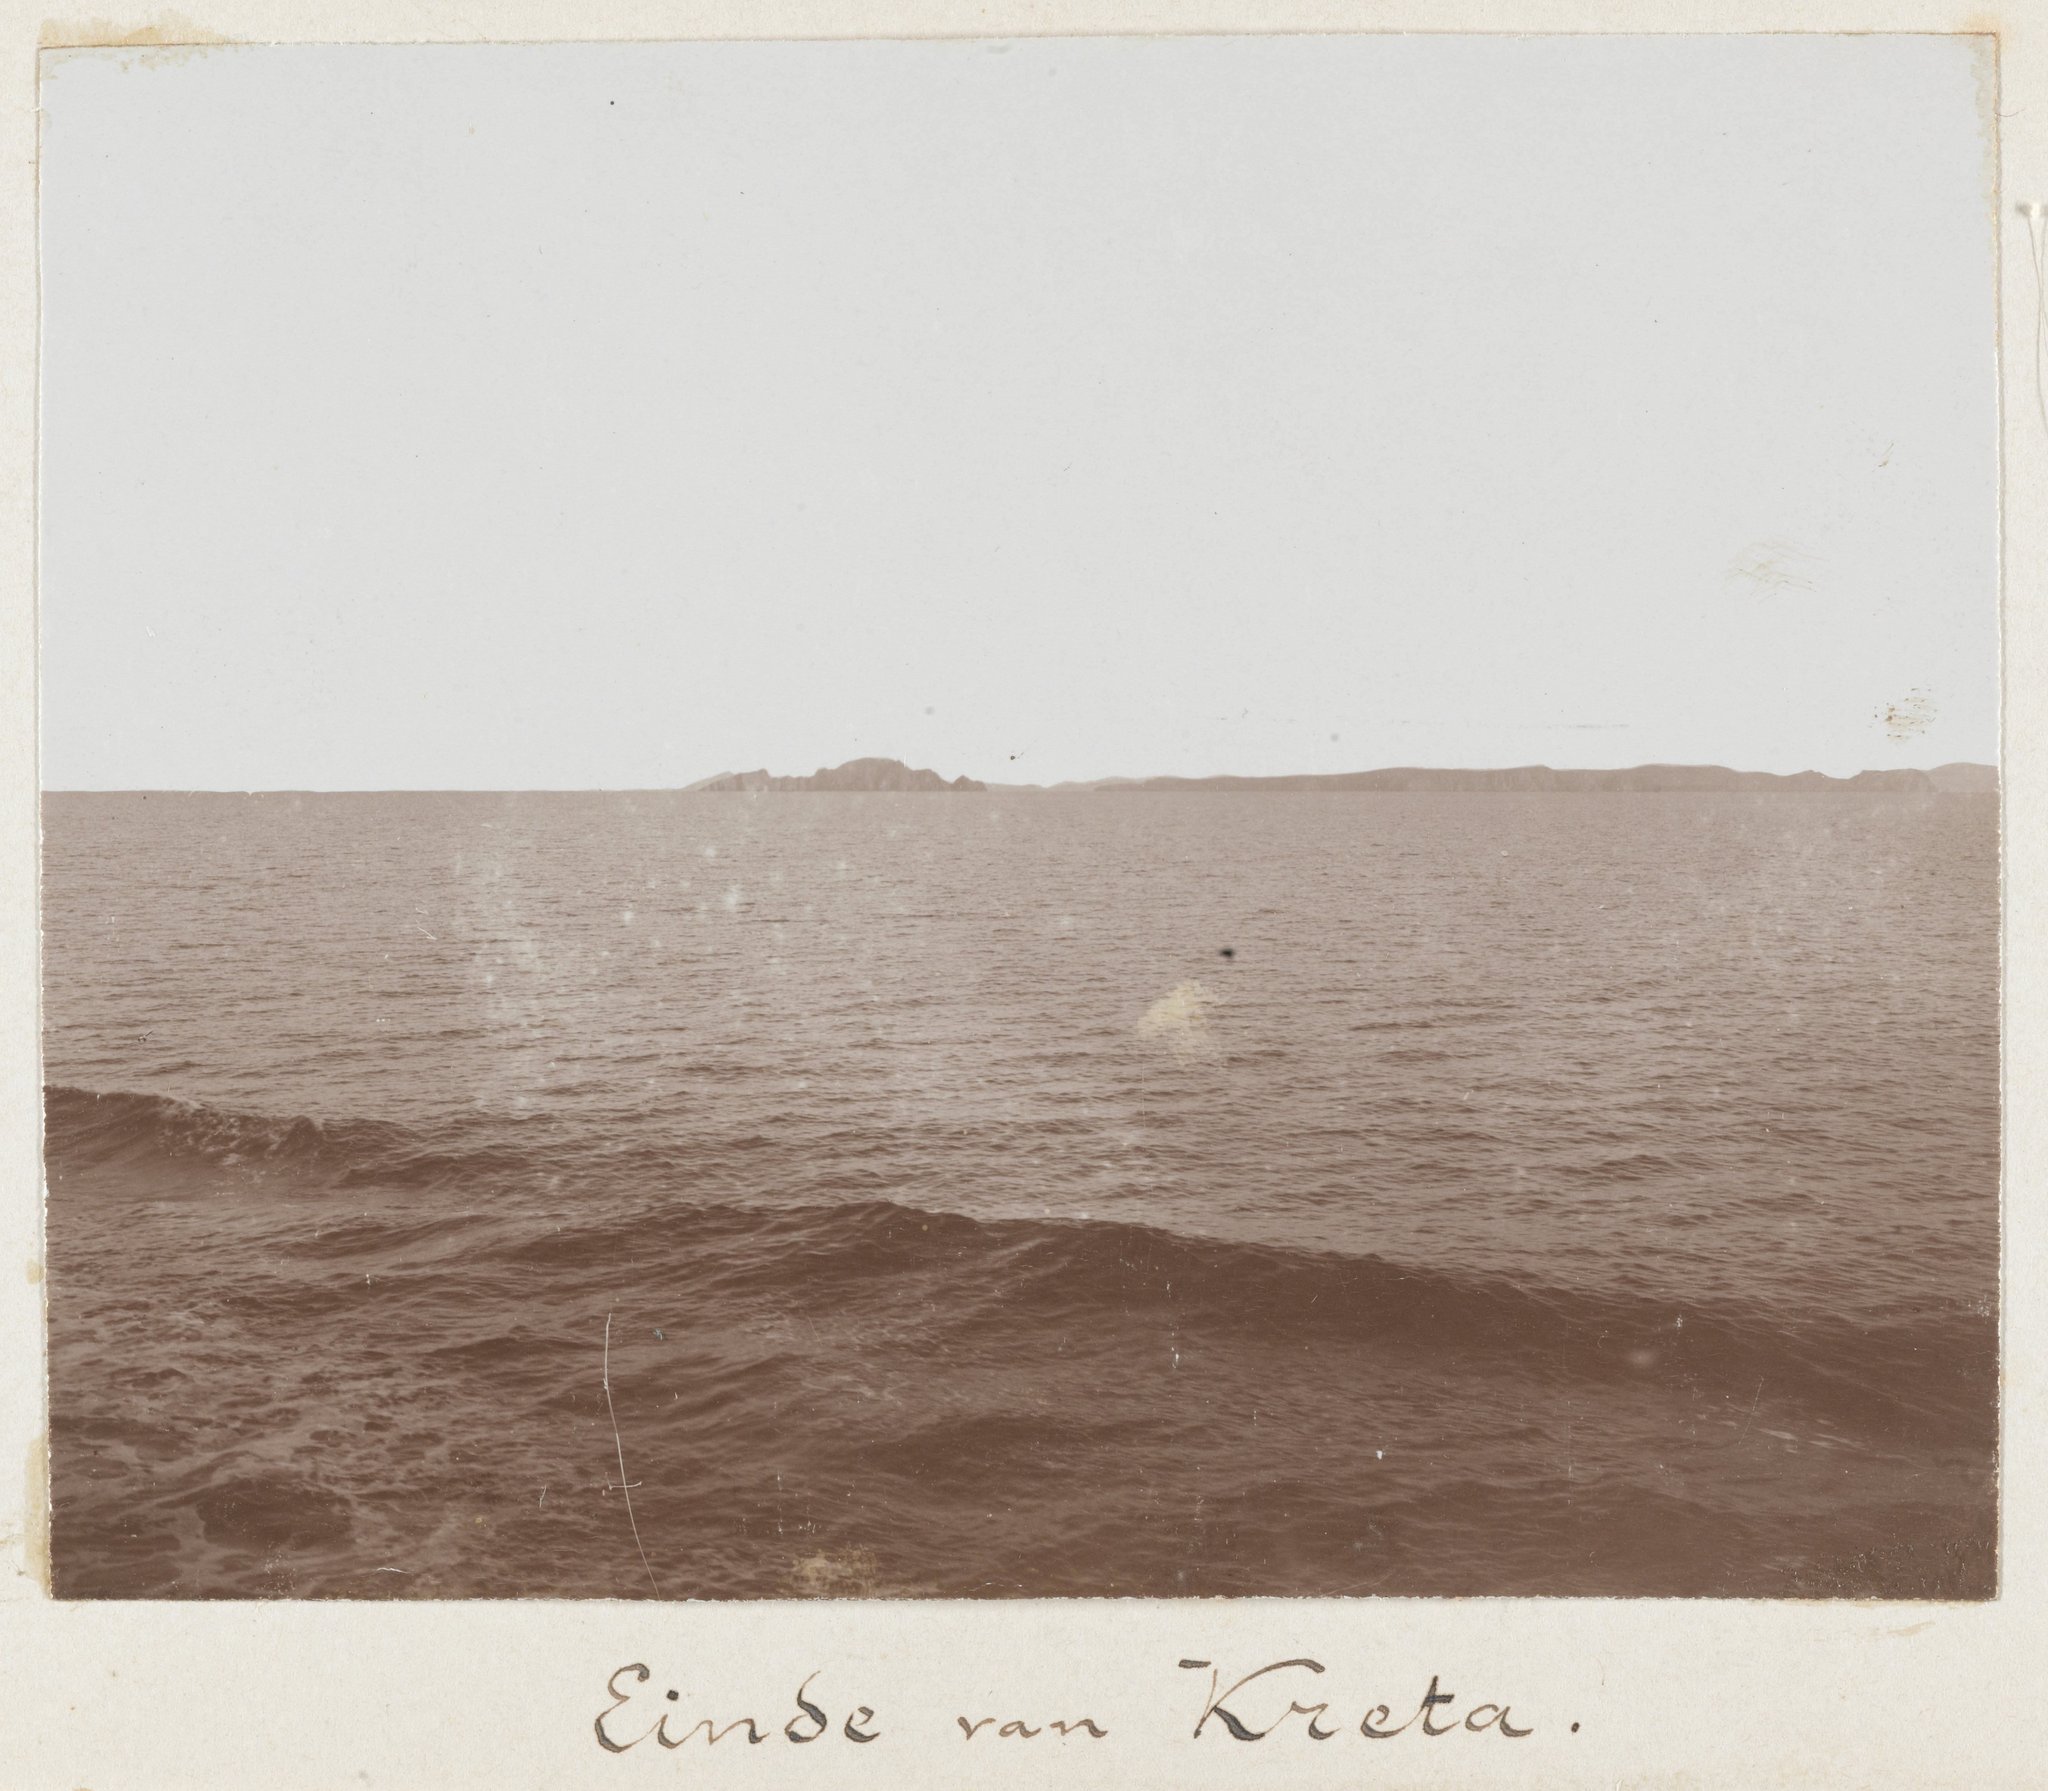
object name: photograph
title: Gezicht over de Middellandse Zee op Kreta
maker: johannes lodewijk heldring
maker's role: fotograaf, predikant, schrijver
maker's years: 1852-1923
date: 1898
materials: paper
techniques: collodion silver print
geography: mediterranean sea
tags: island